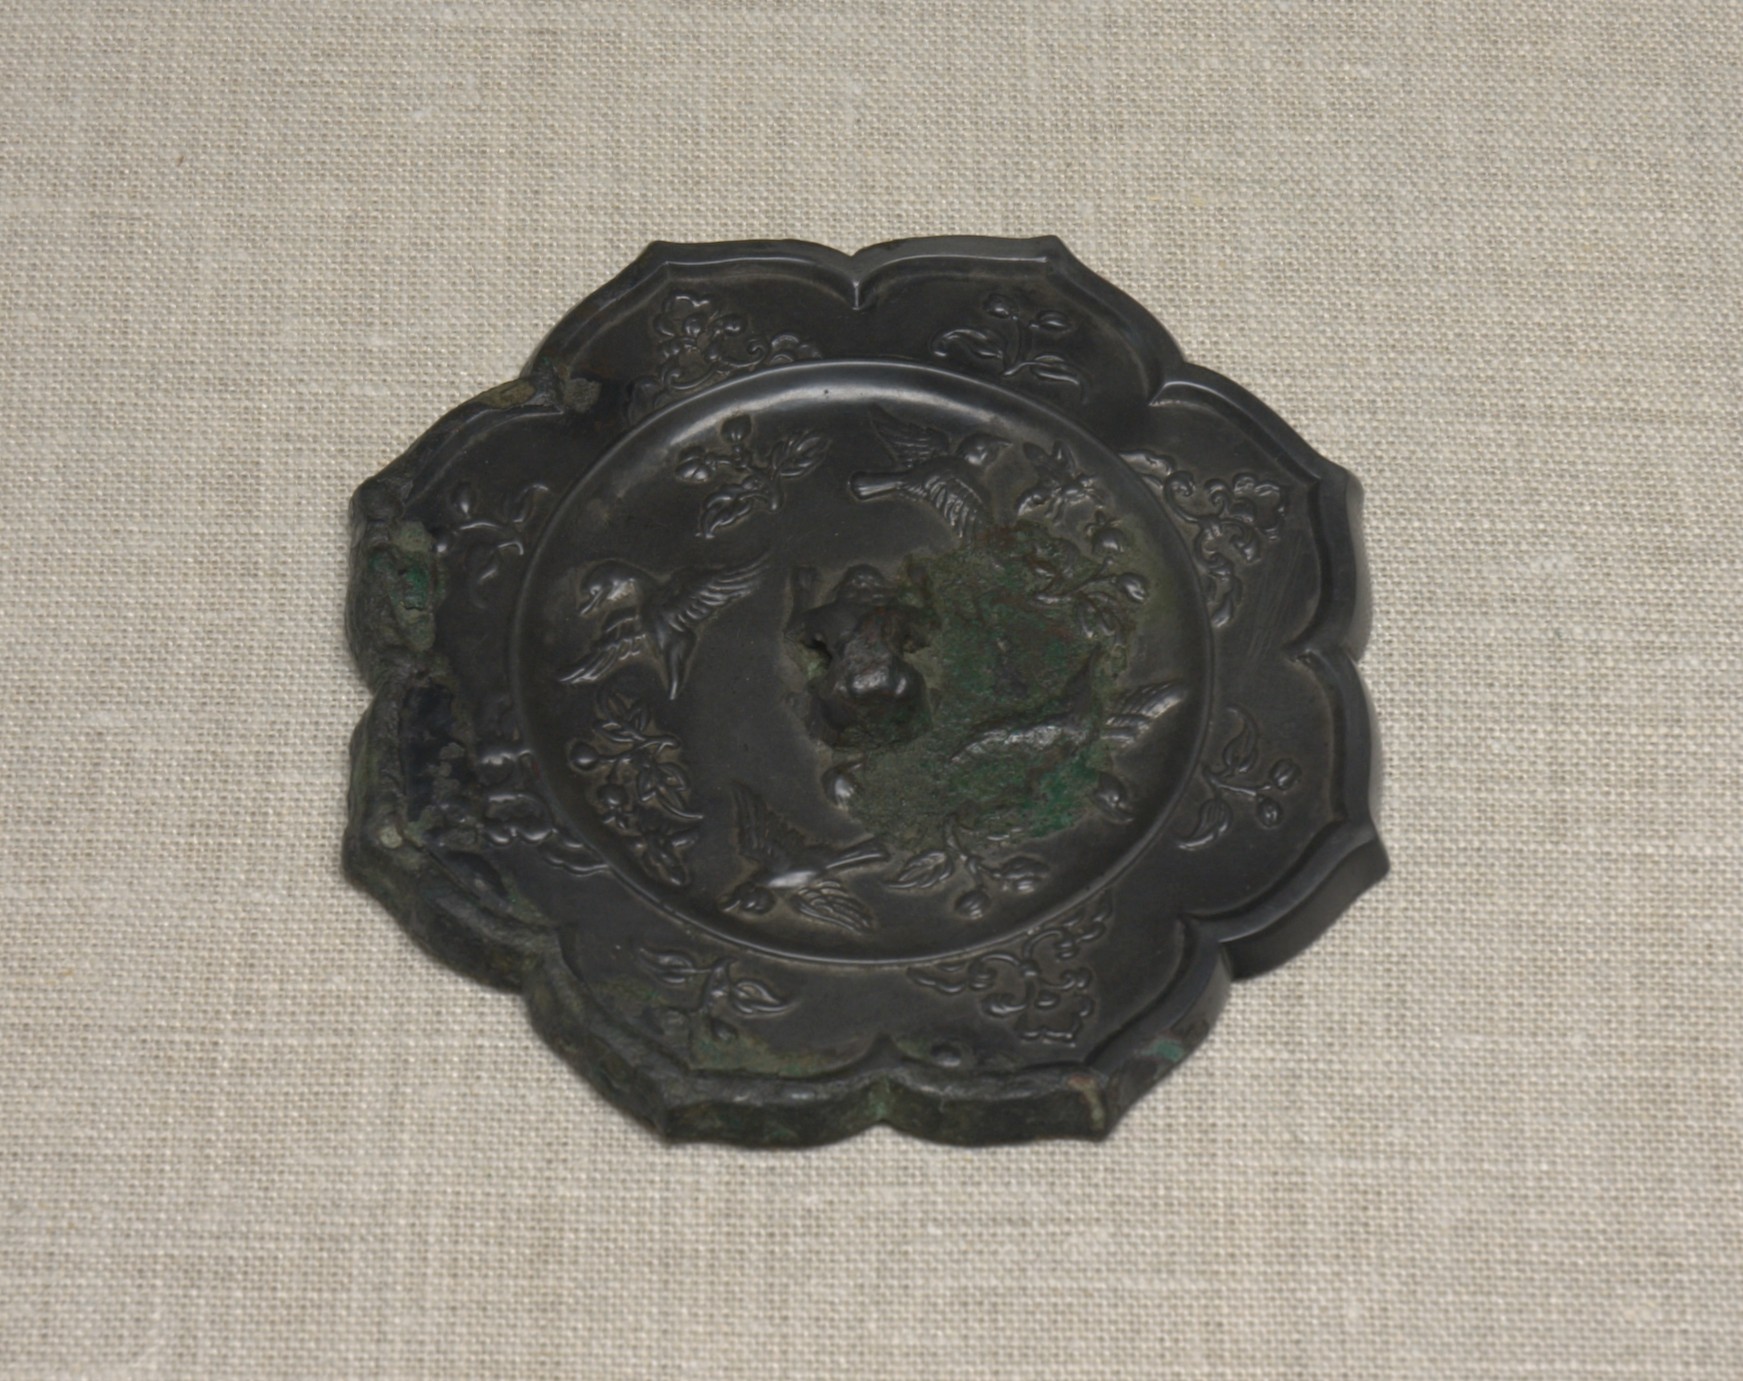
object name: mirror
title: Mirror with birds and flowers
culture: chinese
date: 701-800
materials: bronze, patina